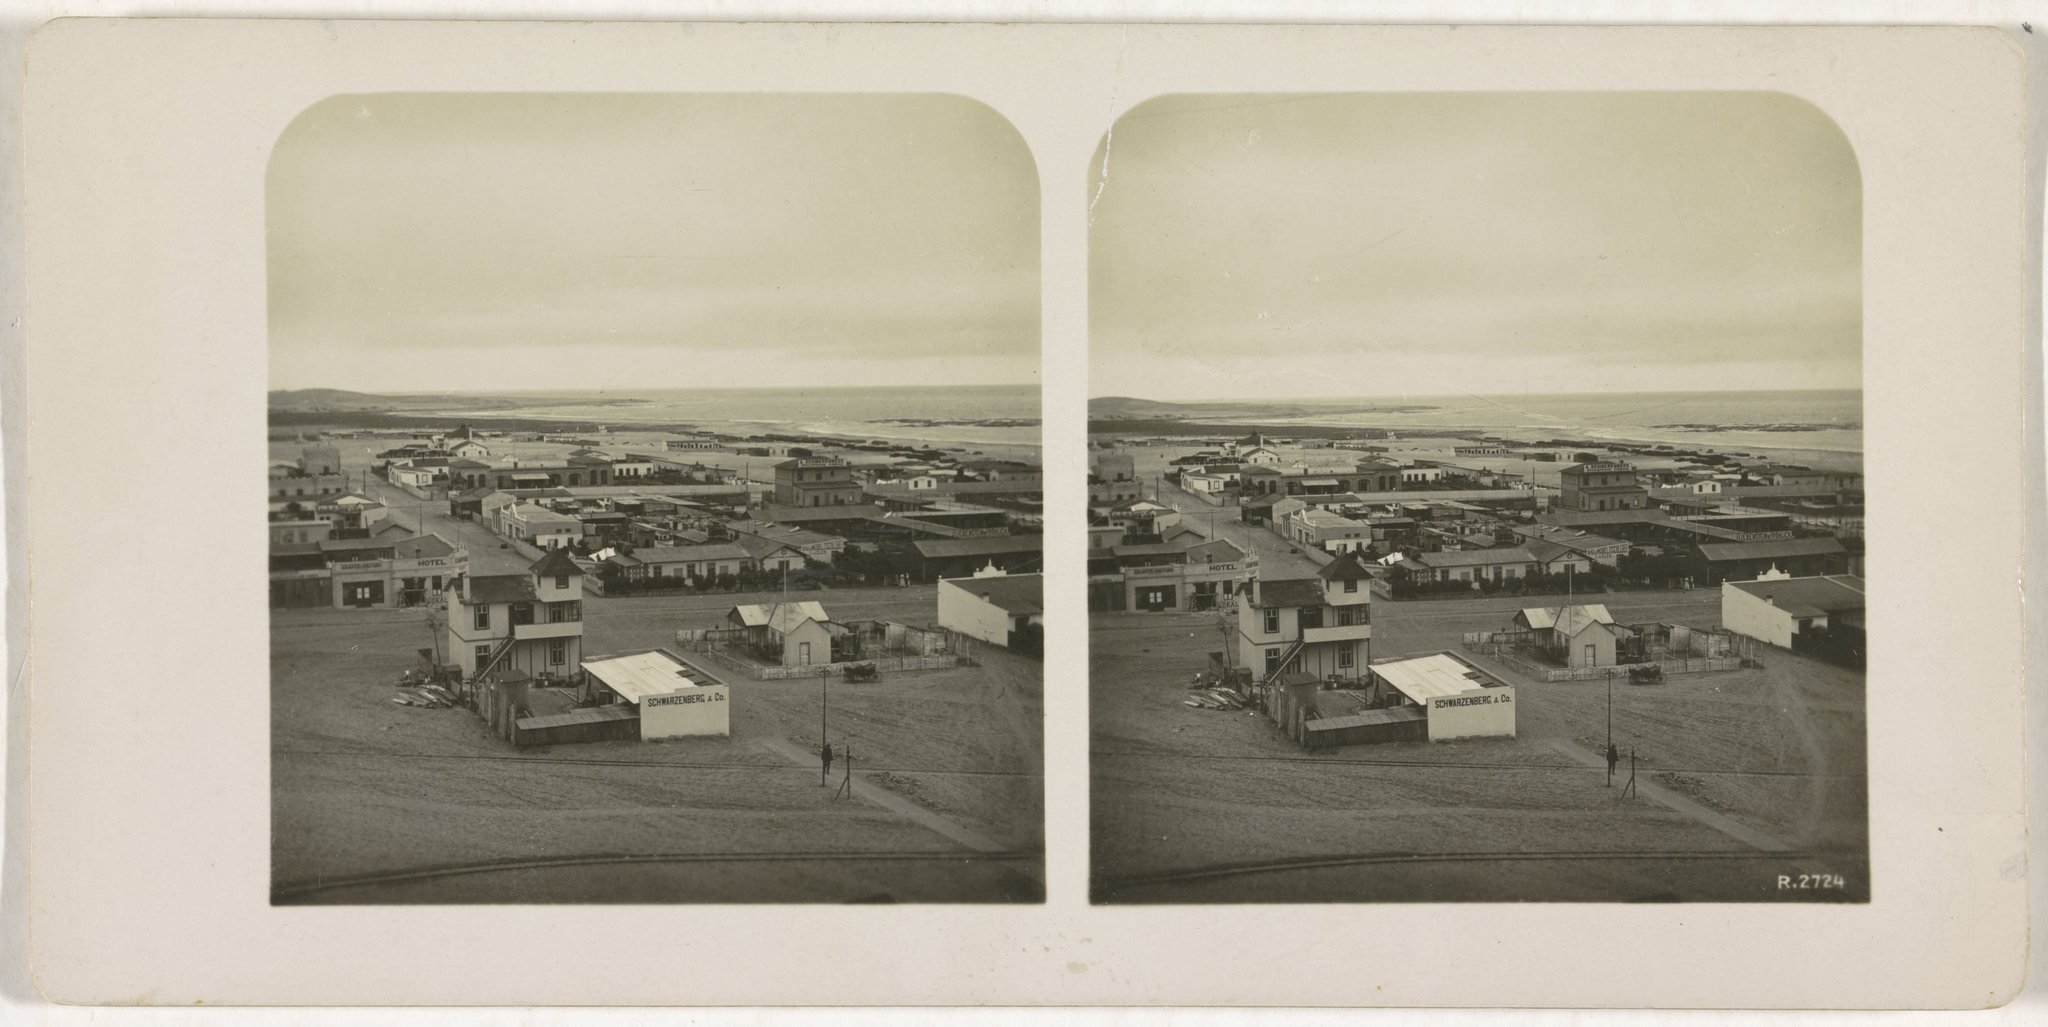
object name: stereograph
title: Gezicht op Swakopmund, Zuidwest-Afrika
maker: Anonymous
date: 1884-1914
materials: cardboard, paper, photographic support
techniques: gelatin silver print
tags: swakopmund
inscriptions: title: ‘Süd-West-Afrika / 2724. / Swakopmund. Panorama’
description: Rechtsonder op de foto rechts staat: R.2724.